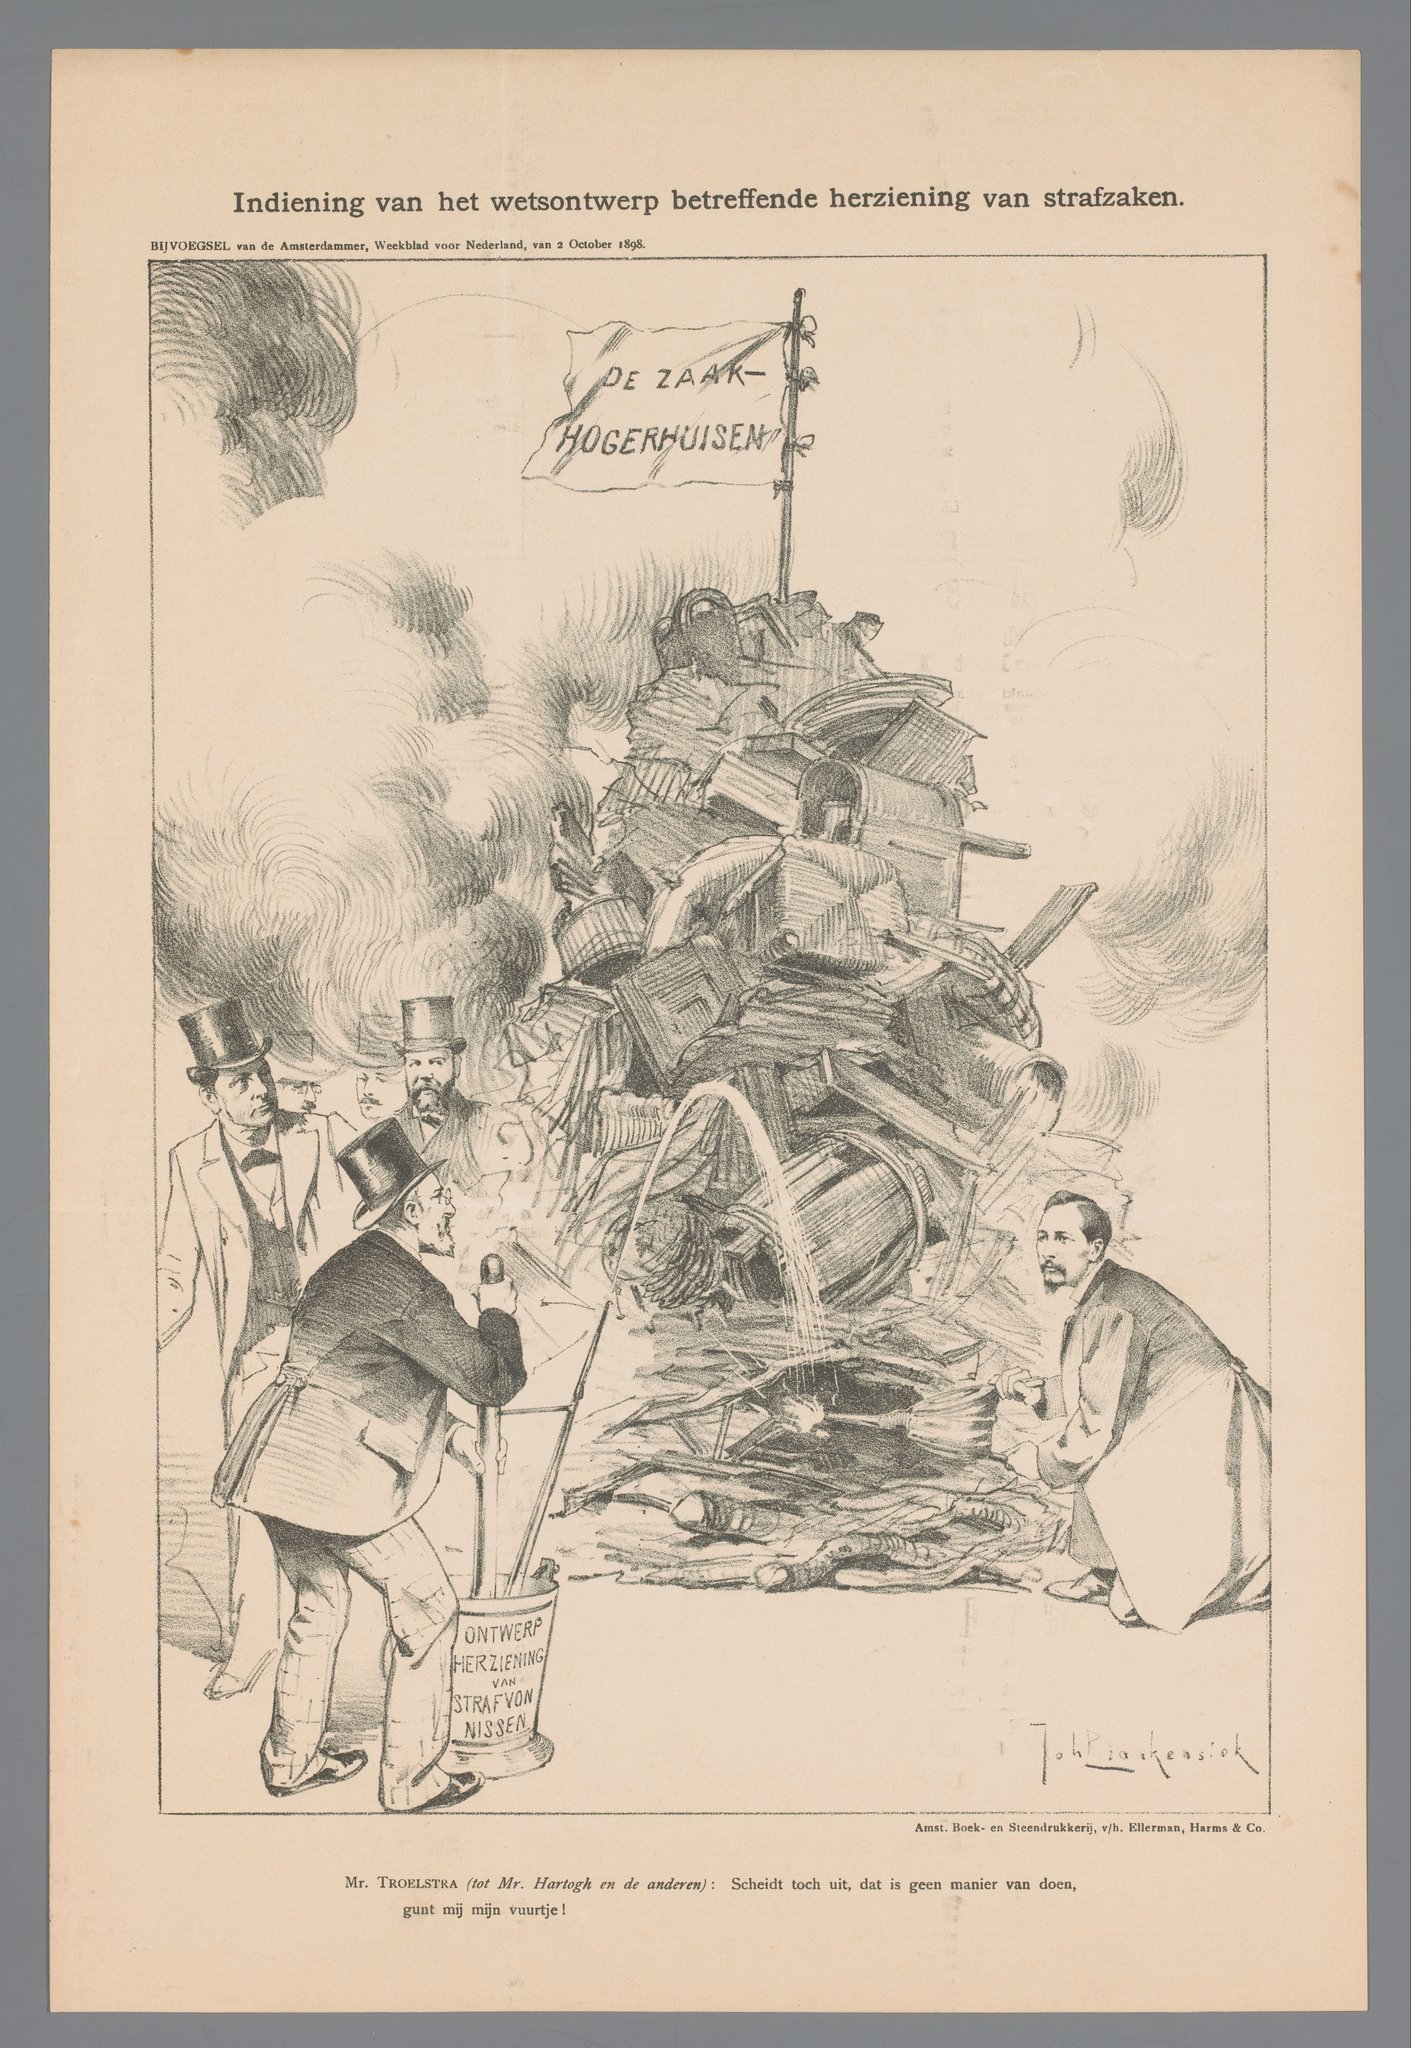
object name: cartoon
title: Indiening van het wetsontwerp betreffende herziening van strafzaken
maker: johan braakensiek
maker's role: draughtsman, print maker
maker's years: 1858-1940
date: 1898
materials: paper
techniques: lithograph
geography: amsterdam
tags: amsterdam, the hague, politician, historical persons, fire-fighting, political caricatures and satires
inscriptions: date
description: Prent uit het bijvoegsel van: De Amsterdammer. Weekblad voor Nederland, 2 oktober 1898.